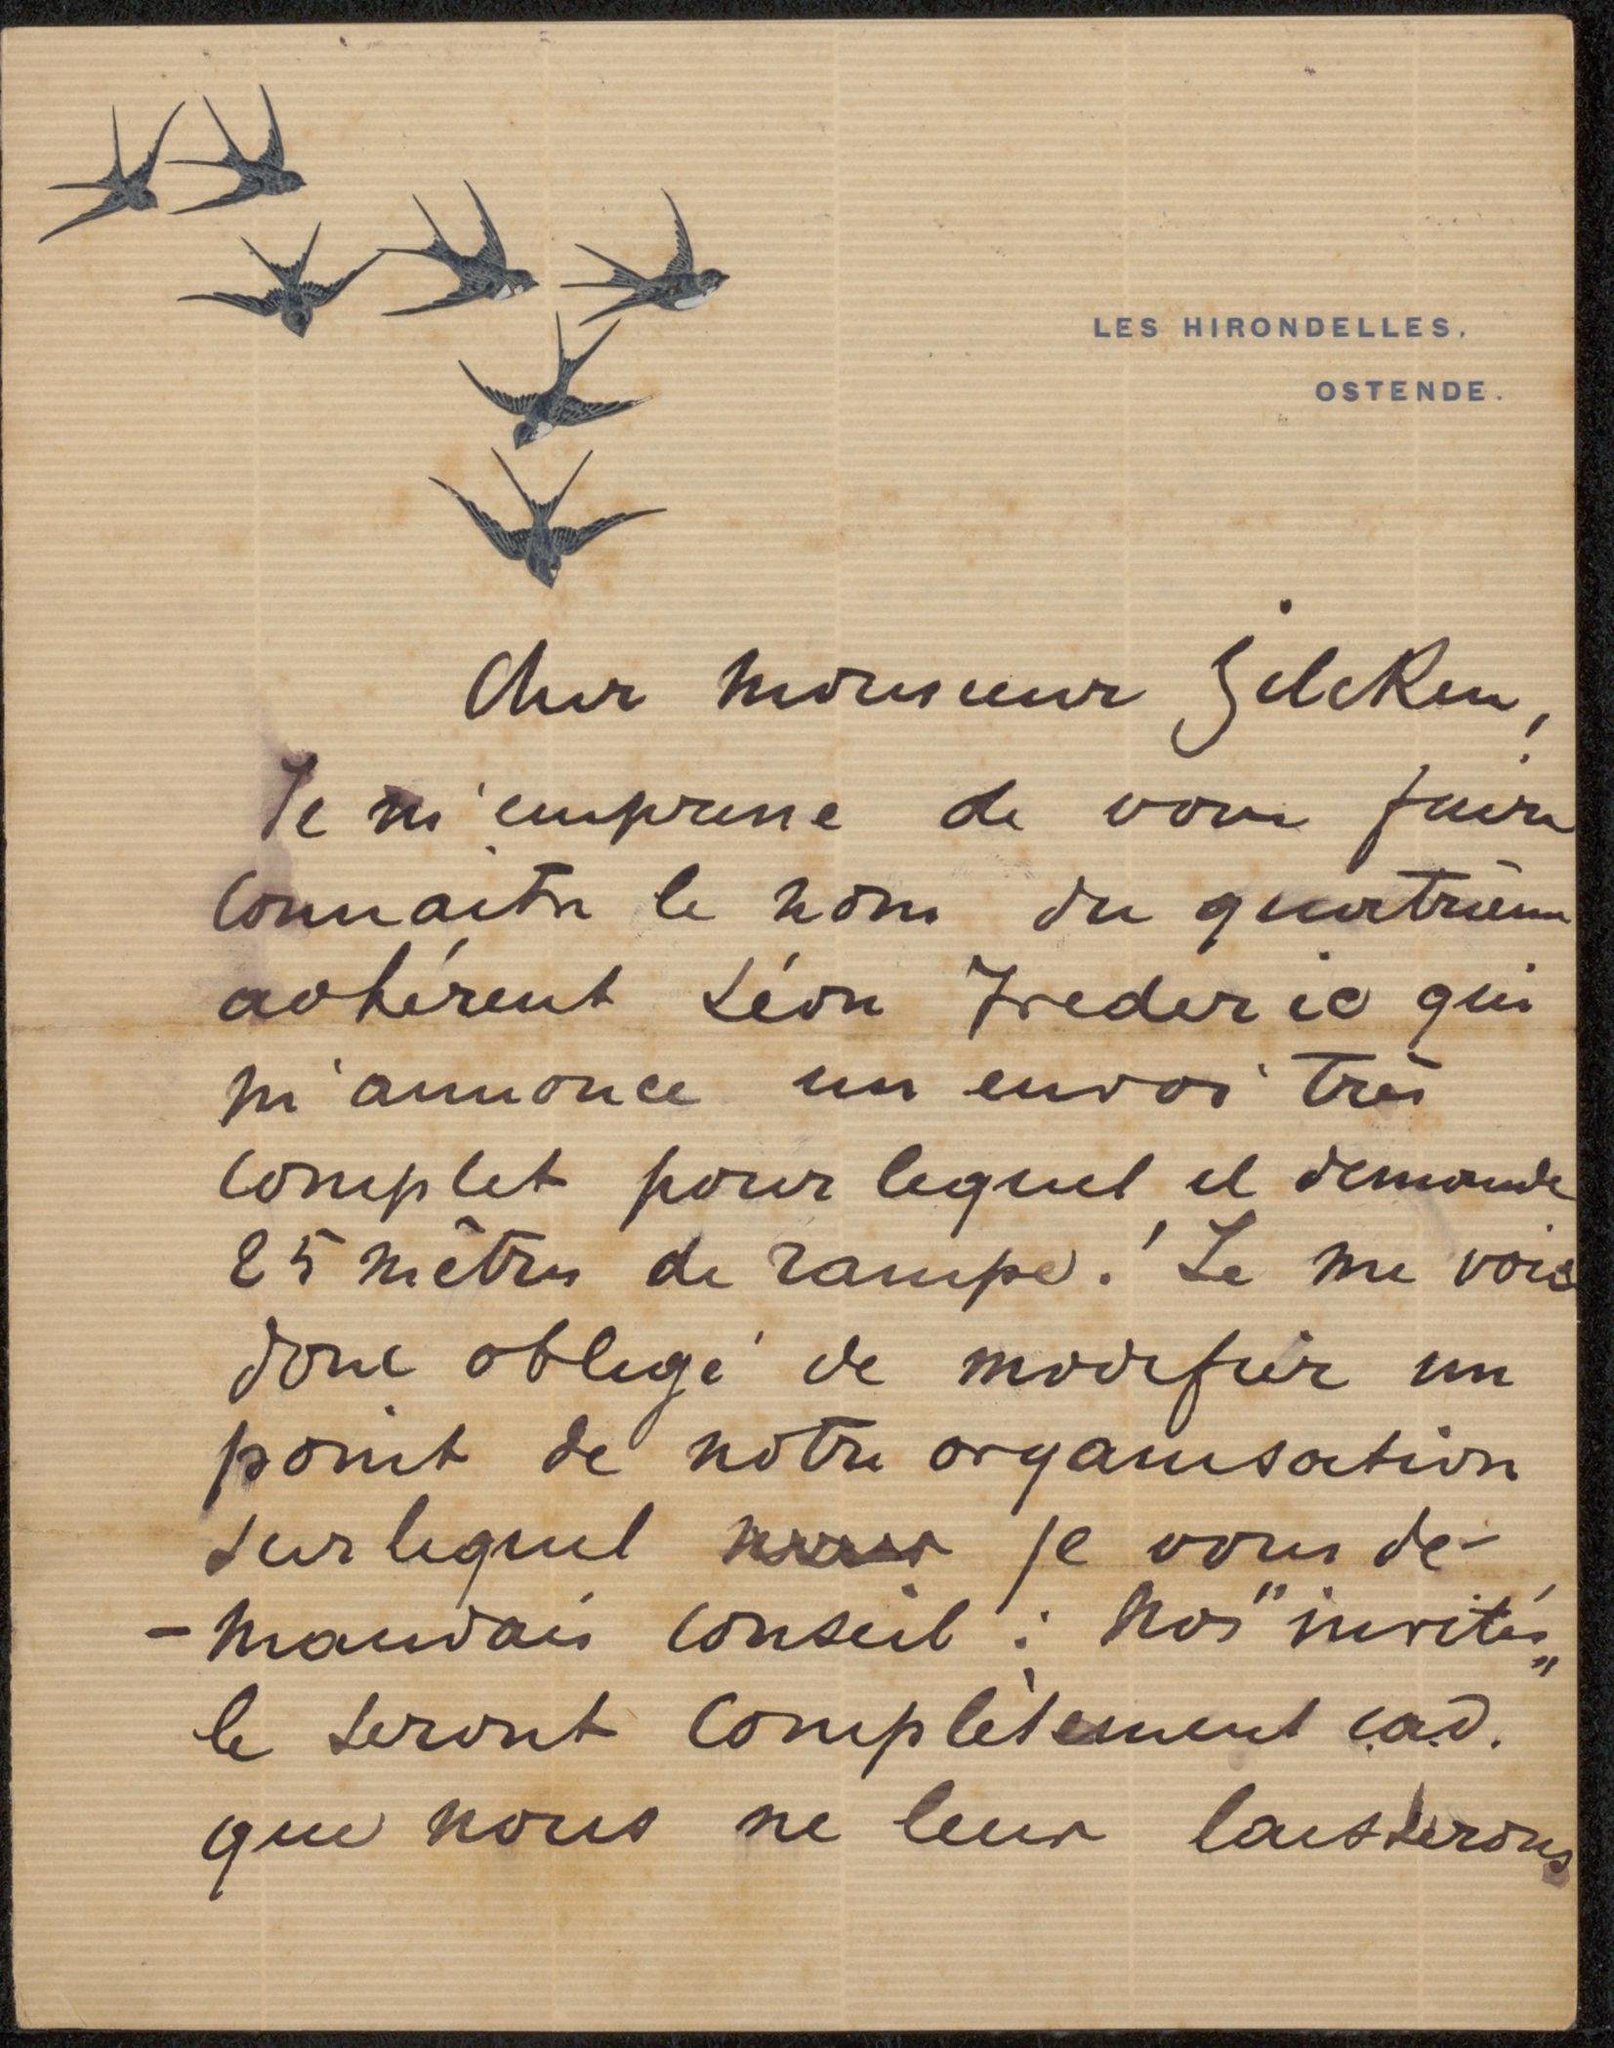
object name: letter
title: Brief aan Philip Zilcken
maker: albert baertsoen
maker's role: draughtsman, print maker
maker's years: 1866-1922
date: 1876-1922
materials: ink, paper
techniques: pen, printing, writing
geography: oostende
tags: emile claus, constantin emile meunier, brussels, the hague, philip zilcken, painting (including book-illumination, miniature-painting), temporary exhibition, 'salon'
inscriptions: collector's mark: ‘RPK’